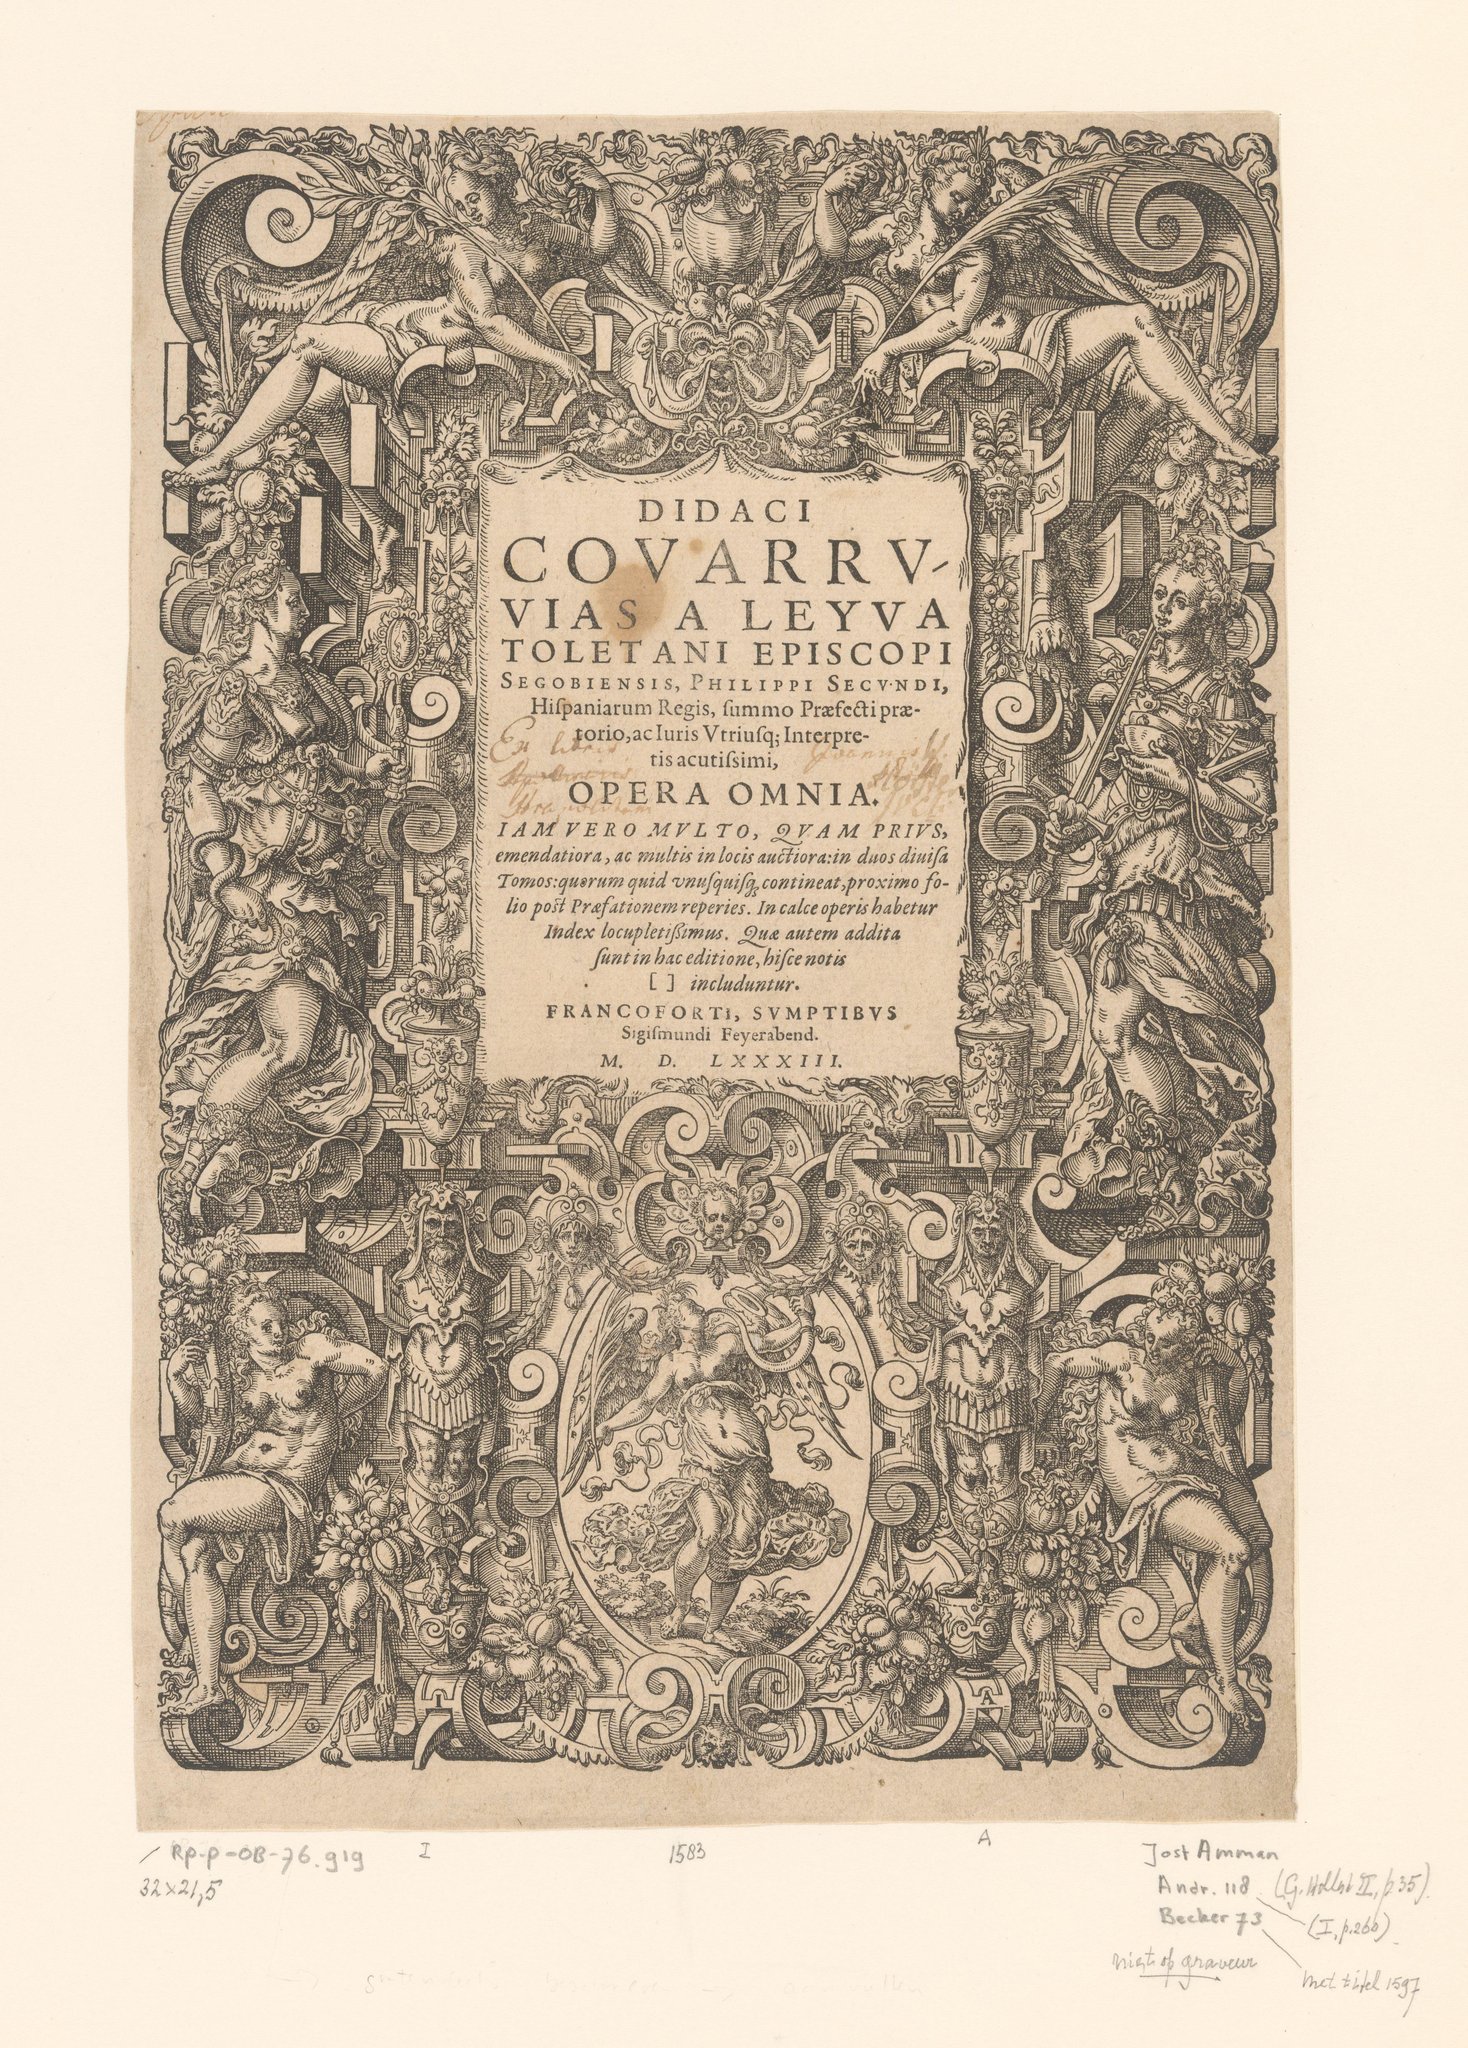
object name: titelblad, titelpagina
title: Architecturale omlijsting met Voorzichtigheid (Prudentia) en Gerechtigheid (Justitia)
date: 1583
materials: paper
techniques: letterpress printing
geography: germany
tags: 'cornucopia', horn of plenty, justice, 'justitia'; 'giustitia divina' (ripa) ~ one of the four cardinal virtues, prudence, 'prudentia'; 'prudenza' (ripa) ~ one of the four cardinal virtues, title-page, device (trade-mark of printer or publisher), fame; 'fama', 'fama buona', 'fama chiara' (ripa)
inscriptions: collector's mark: Lugt 2228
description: Titelprent met titel op een opgespannen rechthoekig doek, gevat in een architecturale omlijsting met rolwerk en allegorische figuren. Bovenaan zitten twee gevleugelde vrouwelijke figuren met olijftak, palmtak en lauwerkransen in de handen. Links staat Voorzichtigheid (Prudentia) met een spiegel in de linker- en slangen in de rechterhand. Rechts staat Gerechtigheid (Justitia) met zwaard en weegschaal. Onder aan de zijkanten zitten twee vrouwelijke figuren met hoornen des overvloeds. Midden onder in cartouche het drukkersmerk van Feyerabend: een staande Fama. Onderaan op rolwerk monogram van Amman: links I en rechts A.